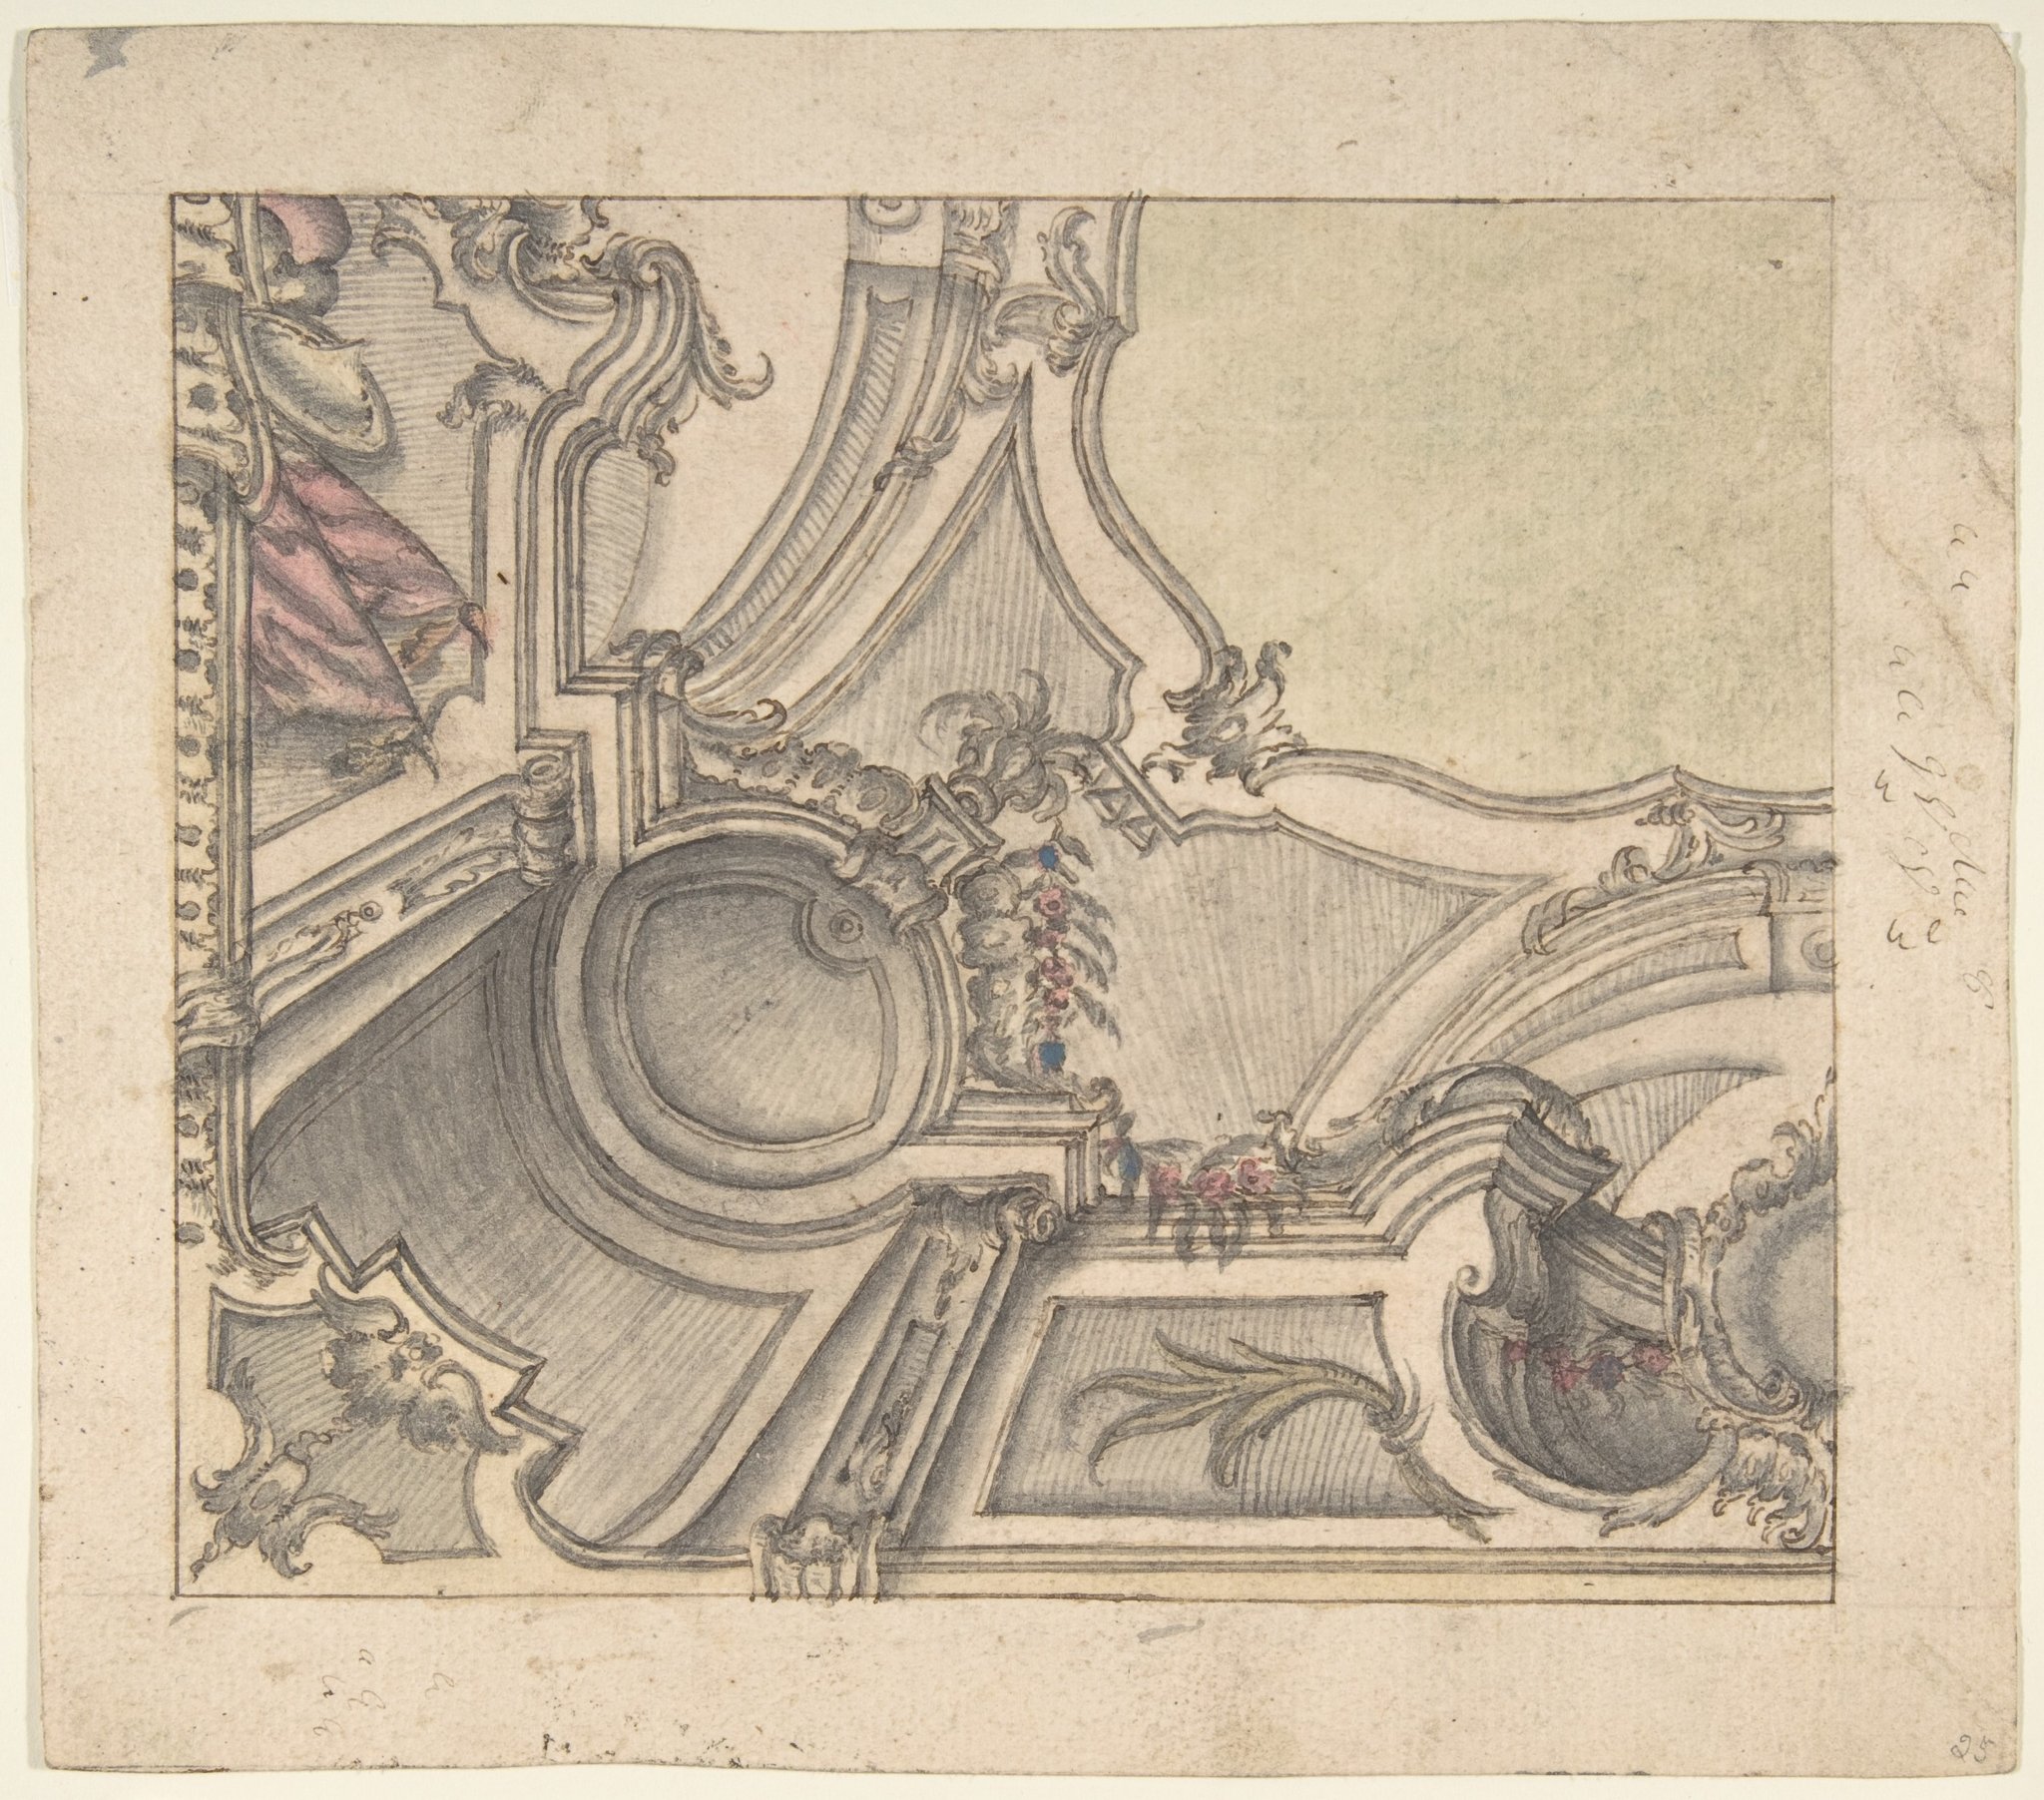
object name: drawing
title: One Quarter of a Design for a Painted Ceiling (recto); Frieze with Putto, Vases, and Other Decorations (verso)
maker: anonymous, italian, piedmontese, 18th century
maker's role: artist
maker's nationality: italian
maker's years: 1700-1800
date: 1700-1780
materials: graphite, ink, drawing material, watercolor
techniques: brush, pen, wash